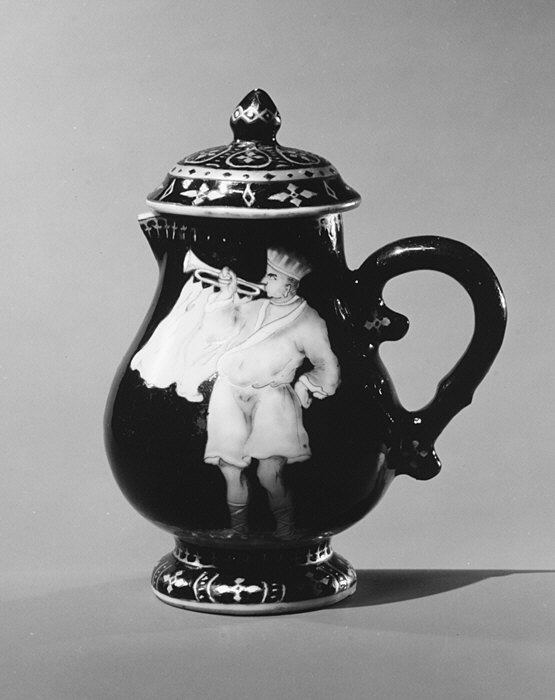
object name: milk jug with cover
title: Milk jug with cover (part of a service)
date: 1780-1790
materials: hard paste porcelain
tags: musical instruments,men